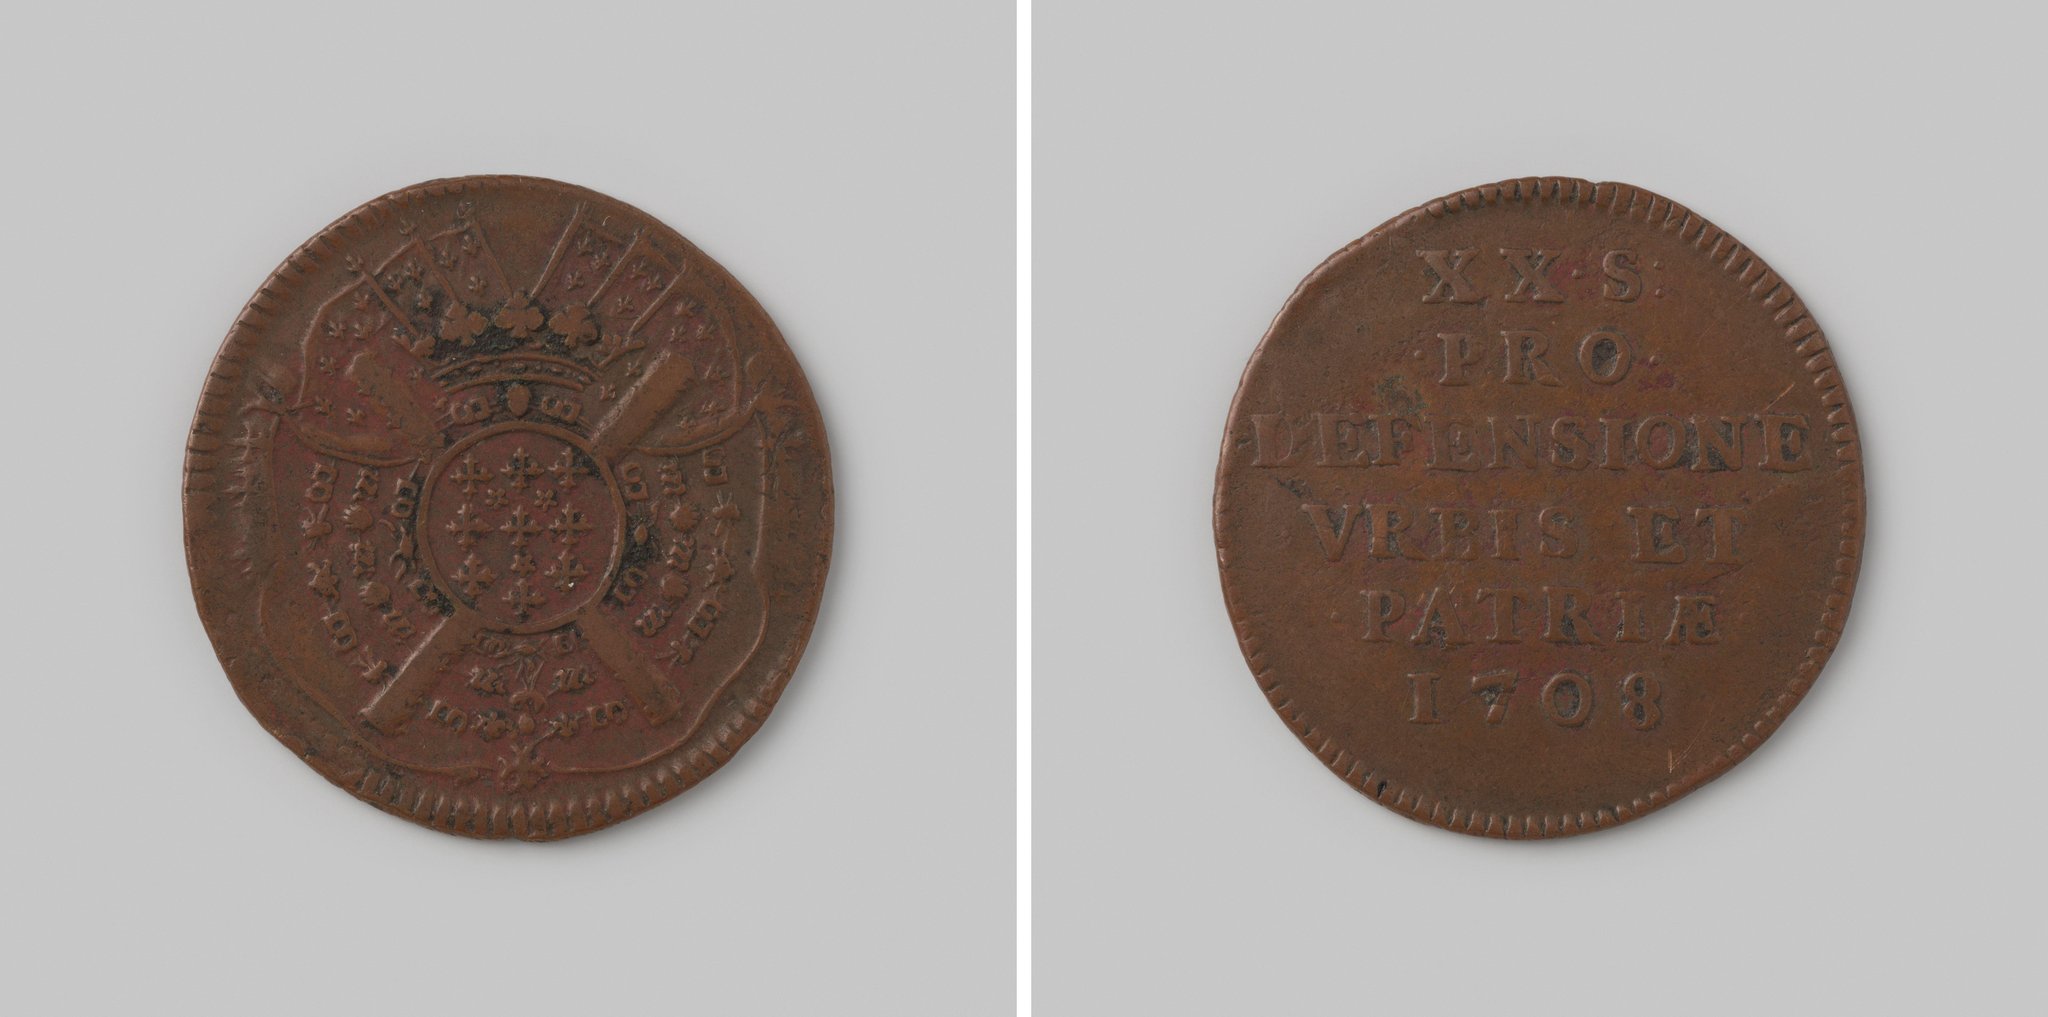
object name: coin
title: Frankrijk, Lille, noodmunt van 20 sols, 1708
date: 1708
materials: copper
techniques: striking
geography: lille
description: Koperen noodmunt. Voorzijde: op stokkenkruis rijk versierd gekroond wapenschild van maarschalk De Boufflers, verdediger van de stad. Keerzijde: op een regel waarde-aanduiding XX S. Daaronder vierregelig opschrift, waaronder jaartal. Kartelrand.